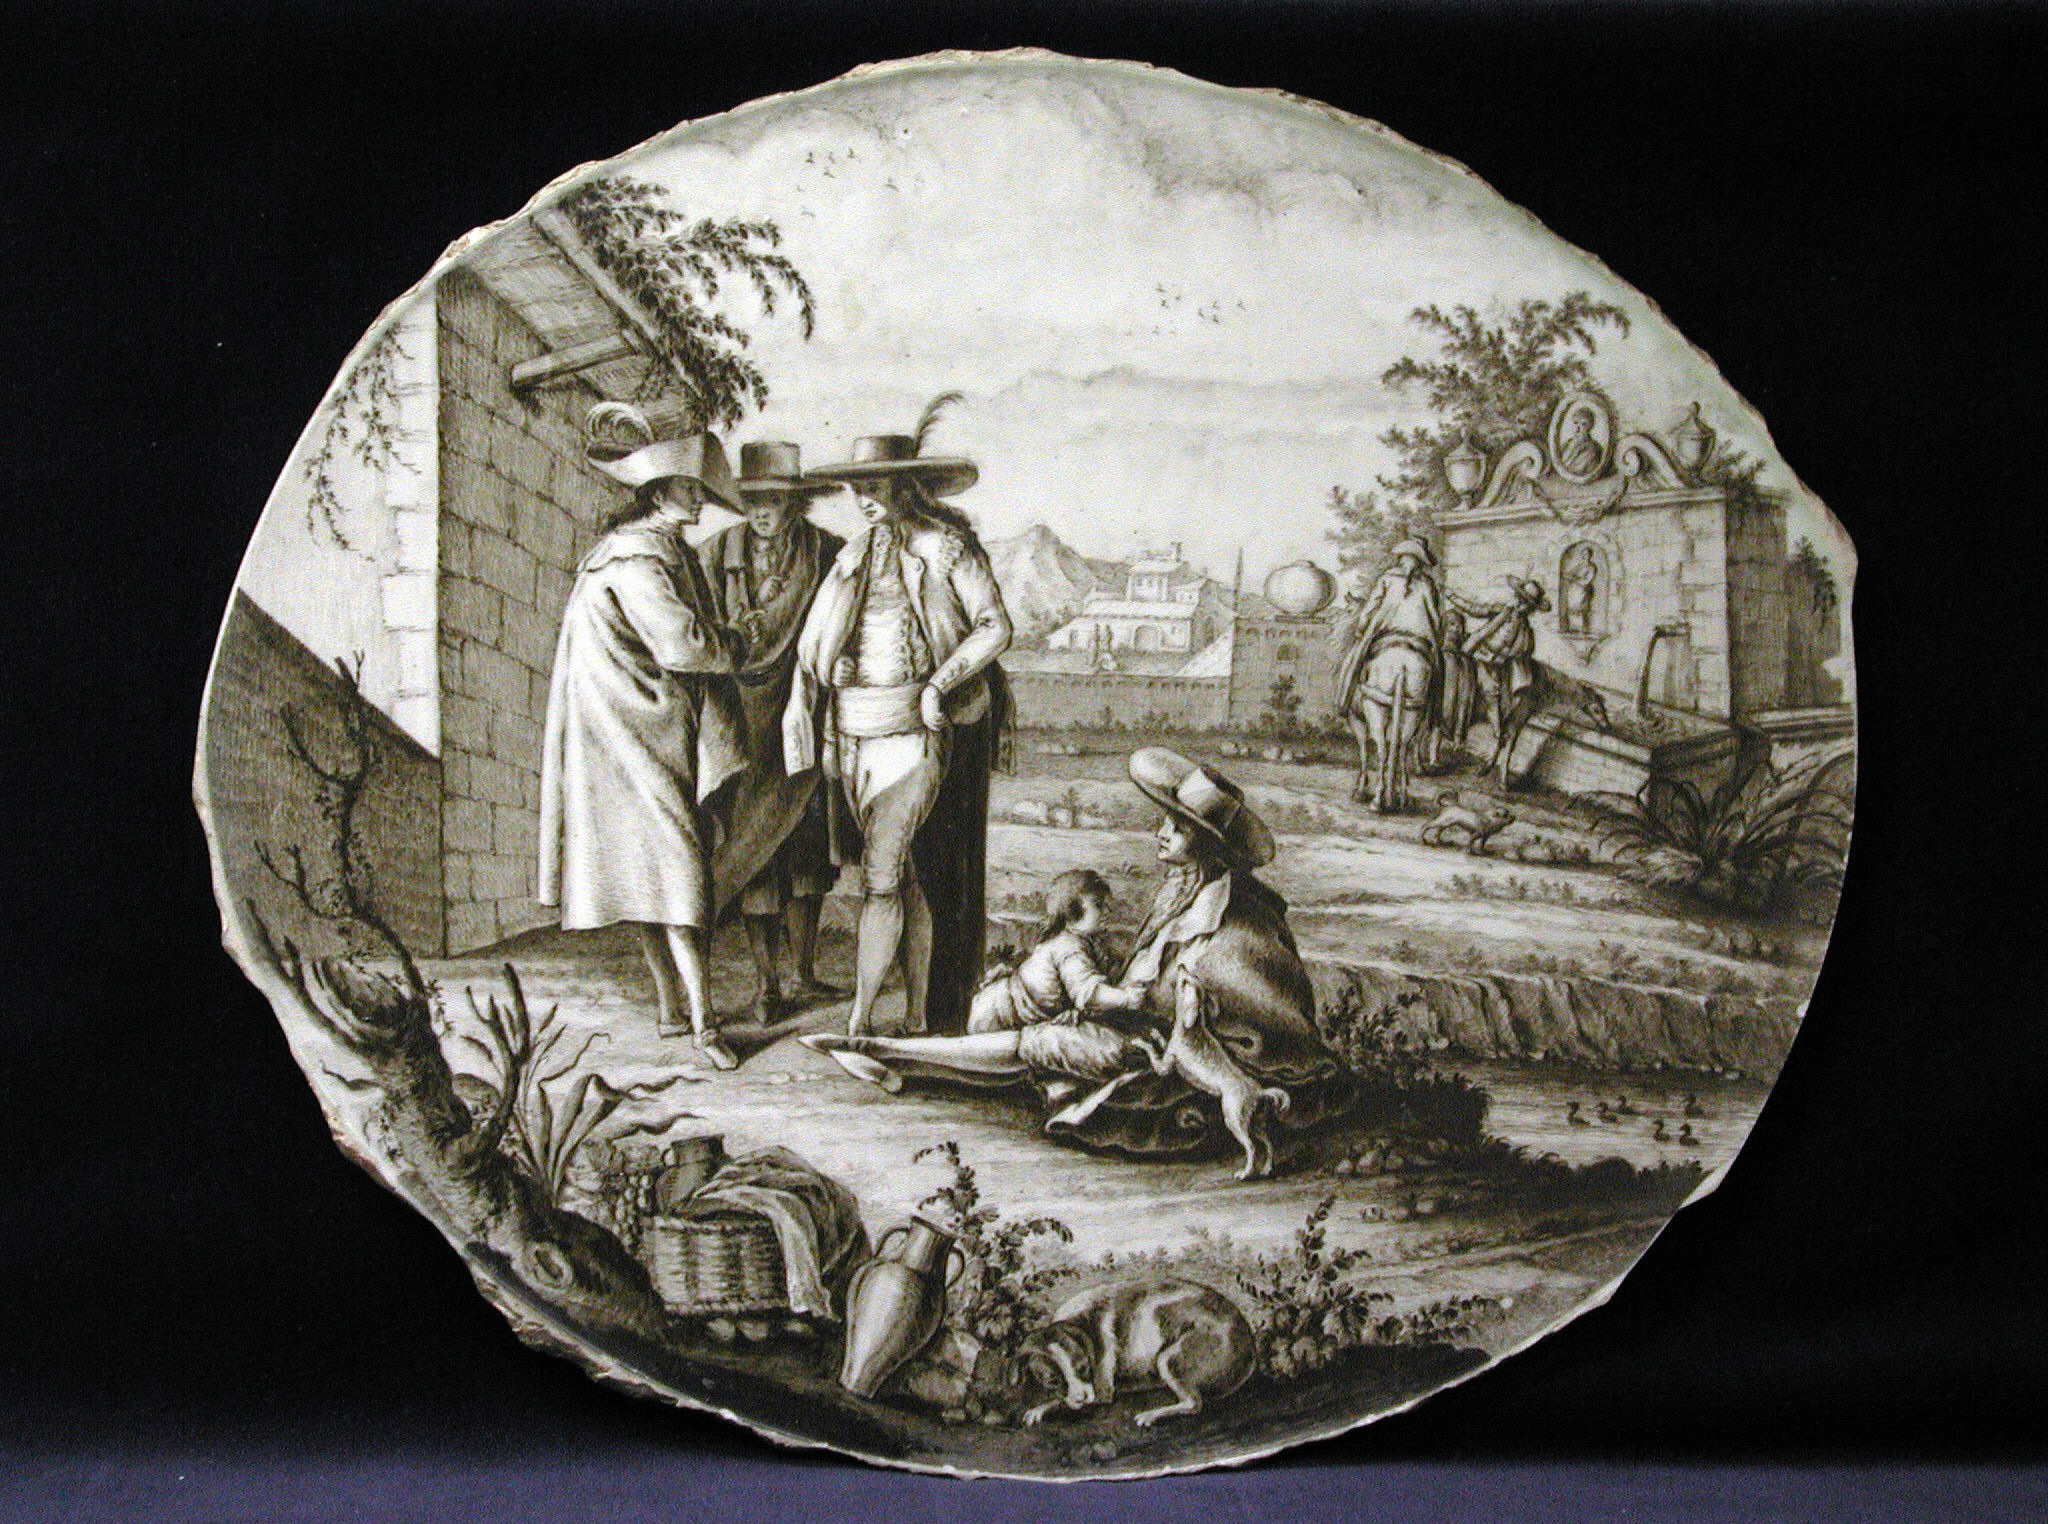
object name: plaque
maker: alcora manufactory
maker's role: factory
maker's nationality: spanish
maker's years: 1727-1895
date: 1767-1800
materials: soft paste porcelain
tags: children,men,women,dogs